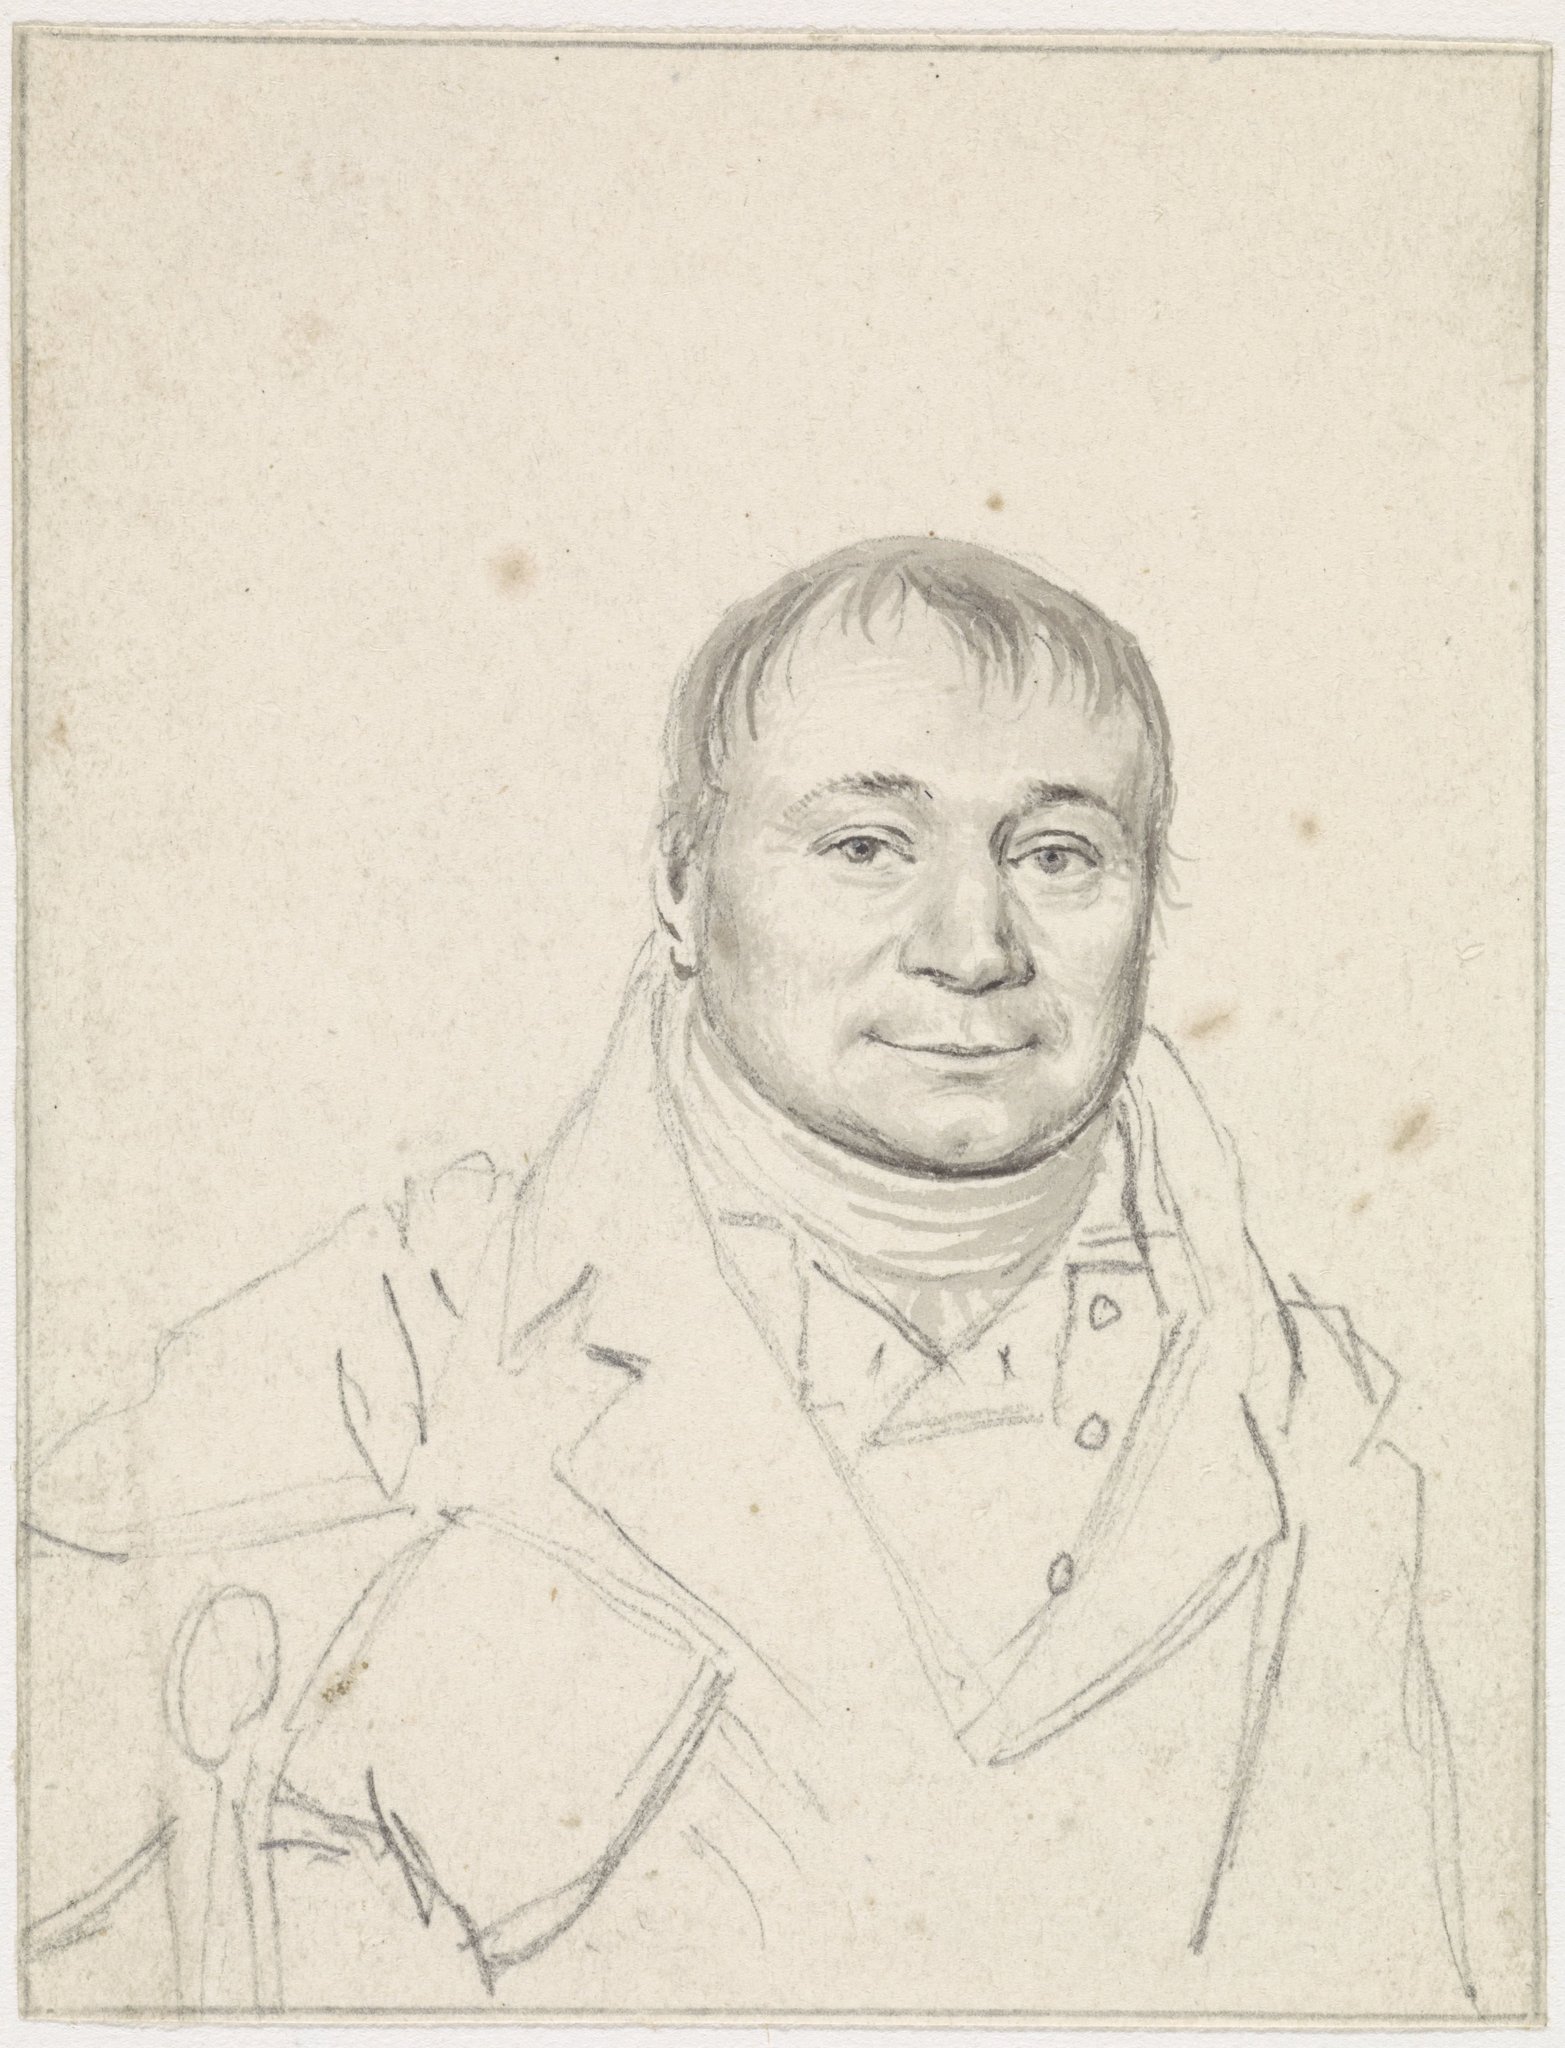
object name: drawing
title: Portret van Chrétien Dubois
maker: hendrik willem caspari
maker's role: draughtsman, print maker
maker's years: 1770-1829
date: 1790-1829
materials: paper, pencil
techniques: brush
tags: chrétien dubois, historical persons, portrait, self-portrait of painter, portrait, self-portrait of artist, portrait, self-portrait of draughtsman